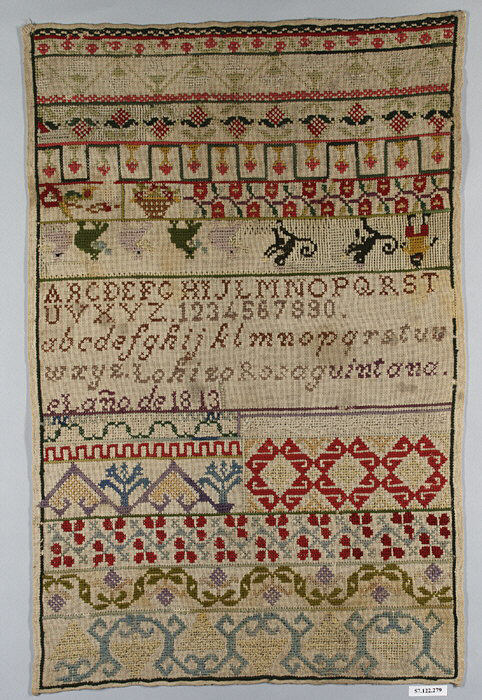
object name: sampler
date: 1813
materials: canvas, wool